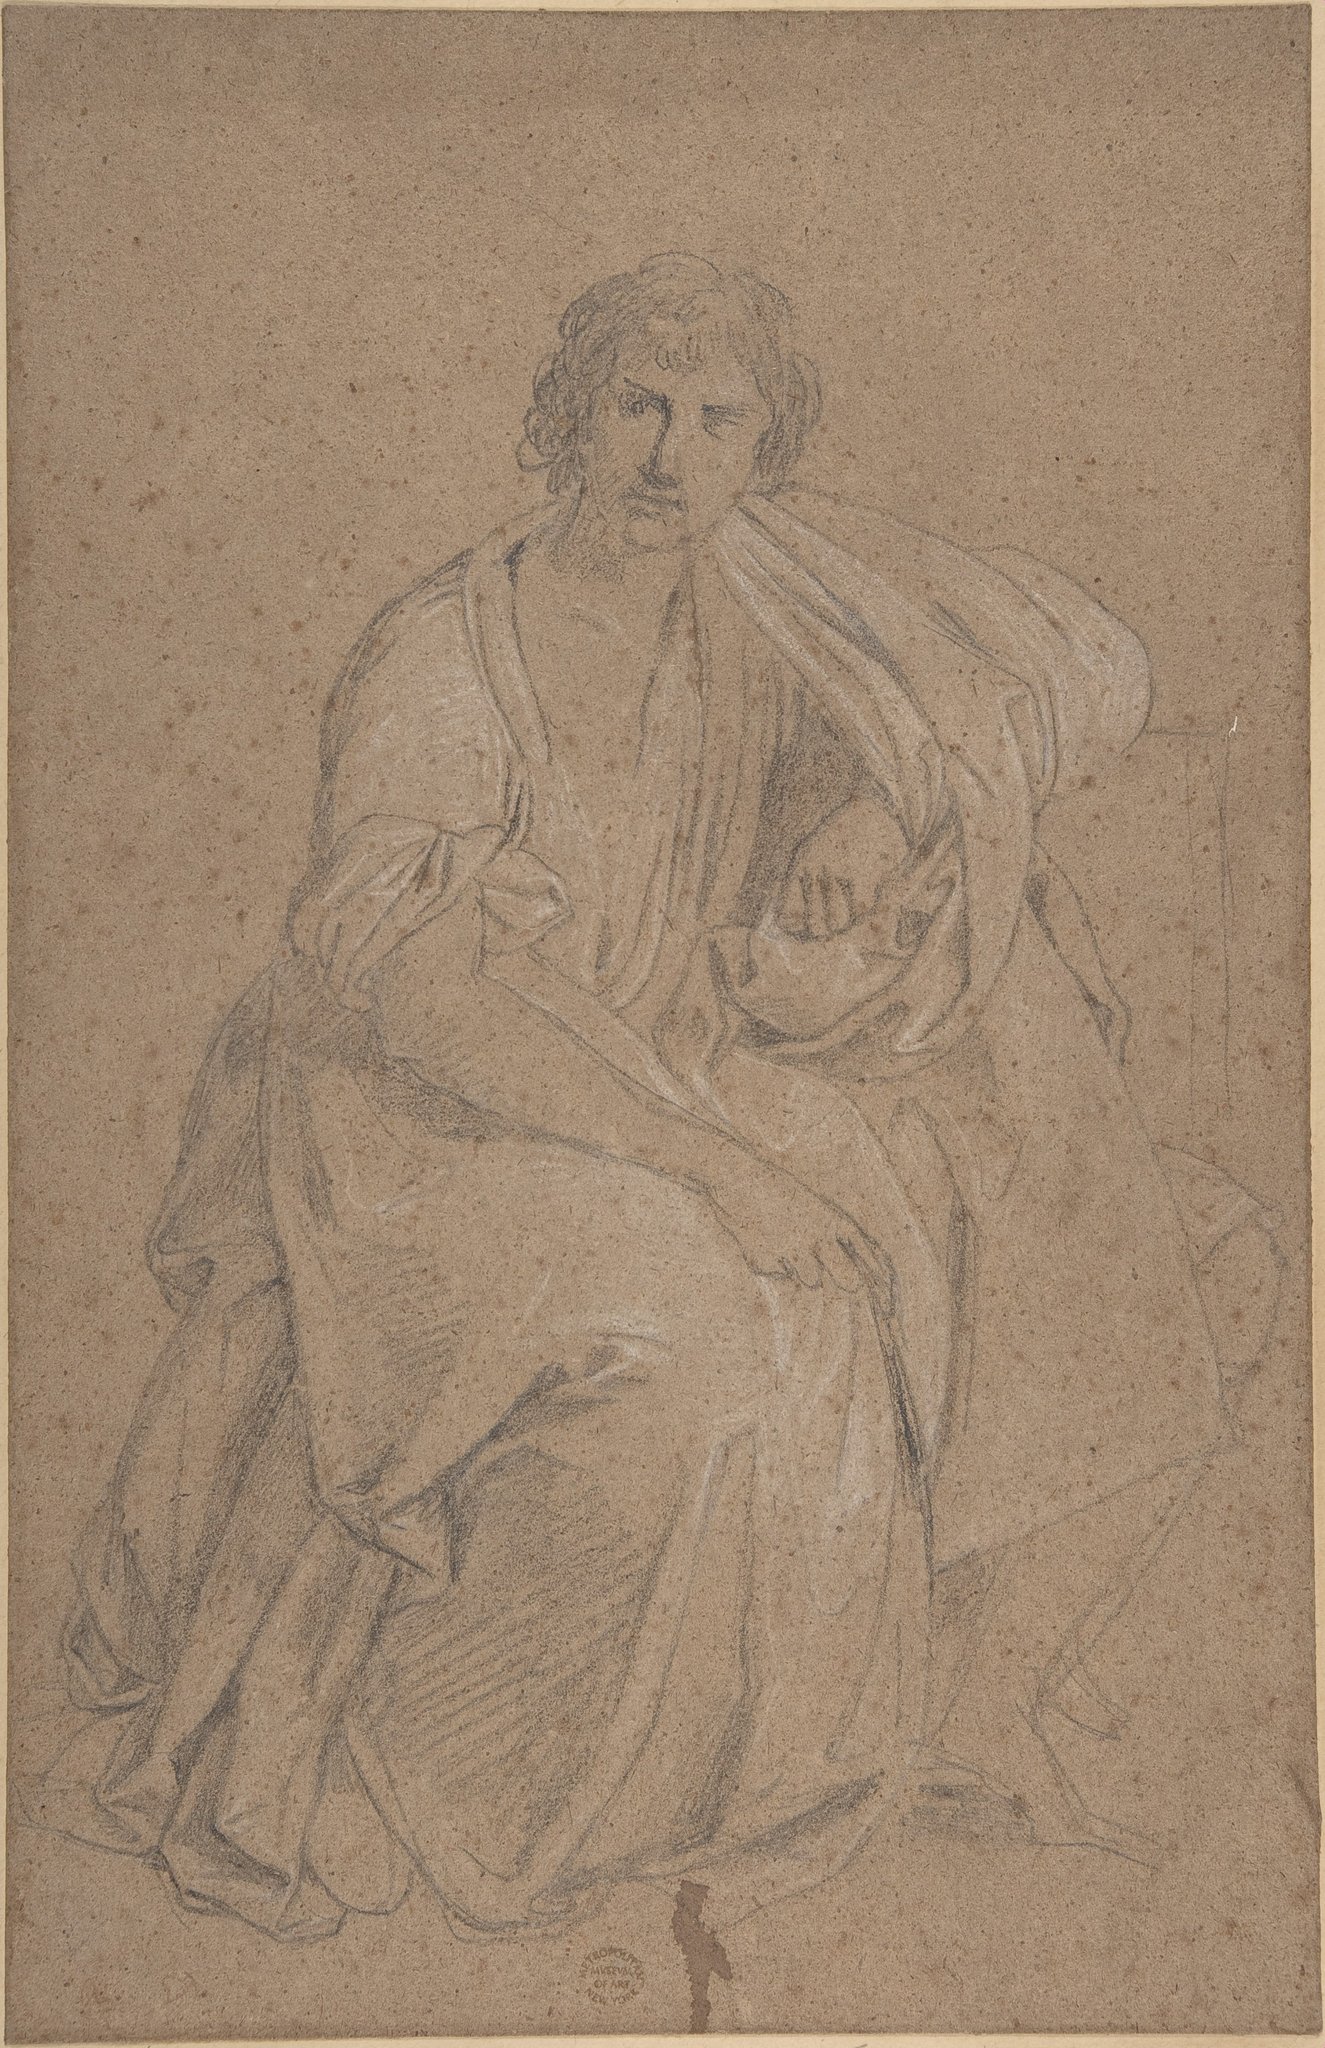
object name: drawing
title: Seated Man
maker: anonymous, french, 18th century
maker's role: artist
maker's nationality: french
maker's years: 1700-1800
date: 1701-1800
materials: chalk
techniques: heightening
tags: men